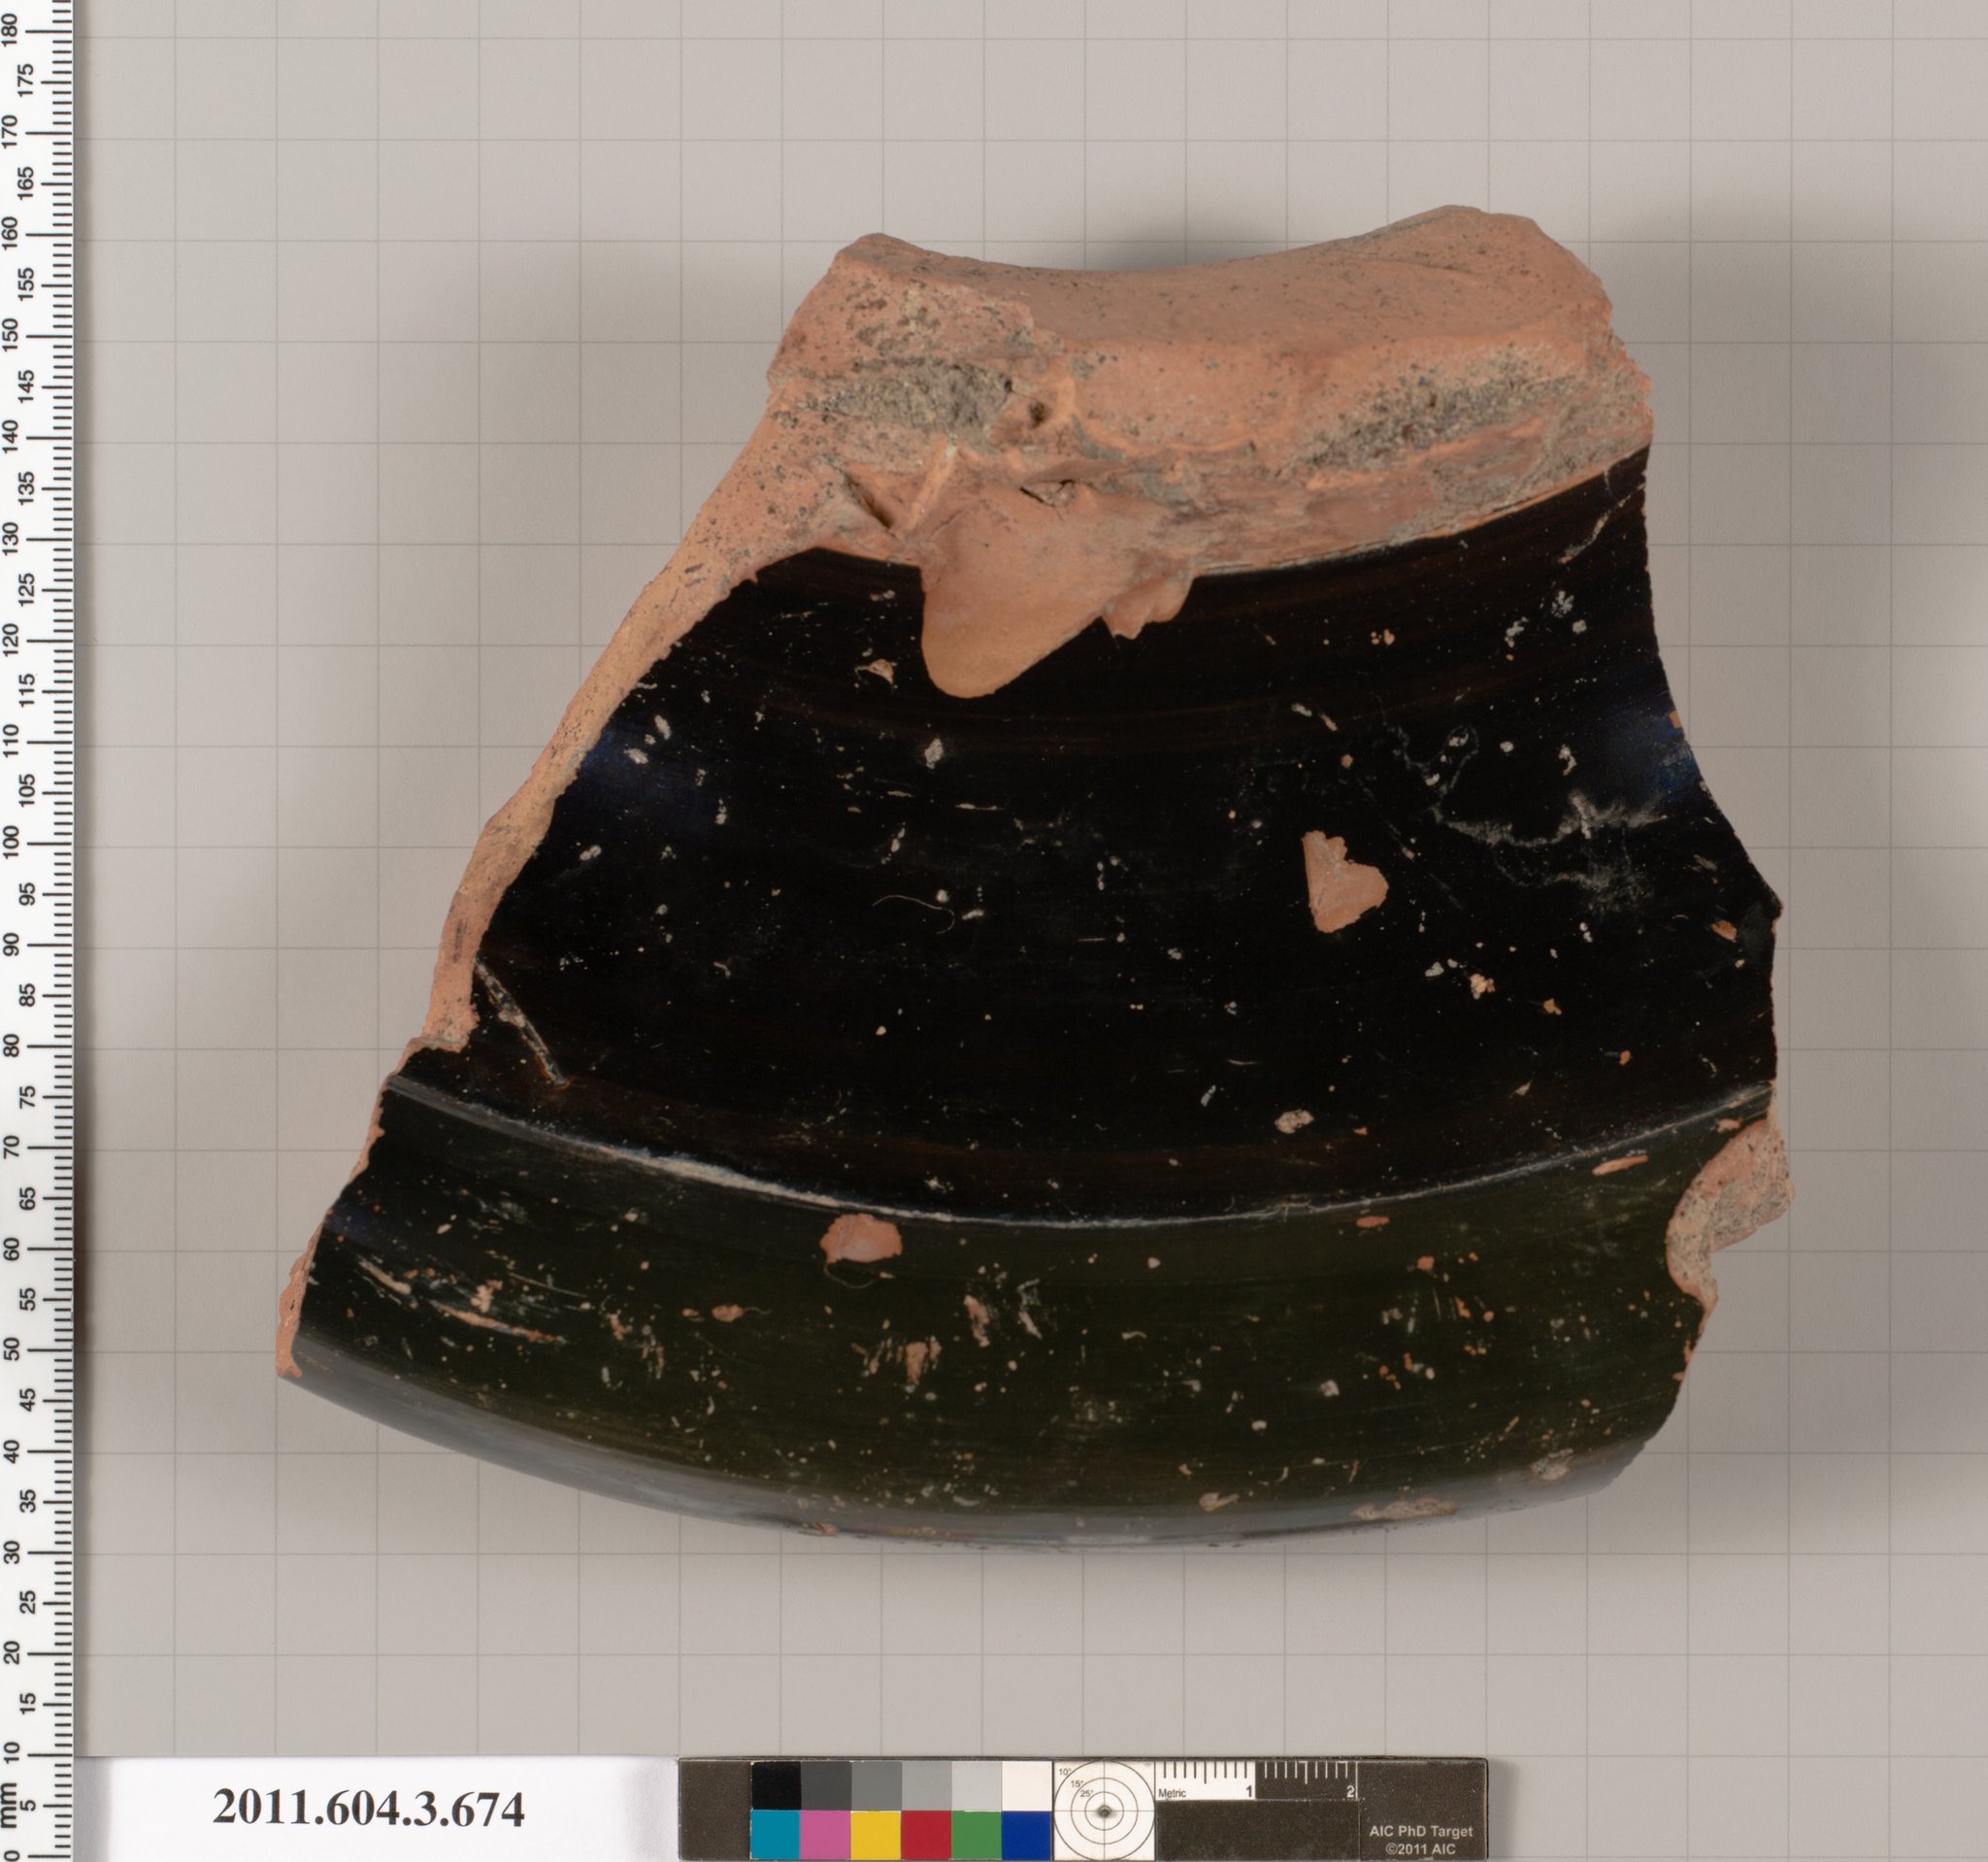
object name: volute krater fragment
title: Terracotta fragment of a volute-krater (bowl for mixing wine and water)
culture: greek, attic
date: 600-401 BCE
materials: terracotta